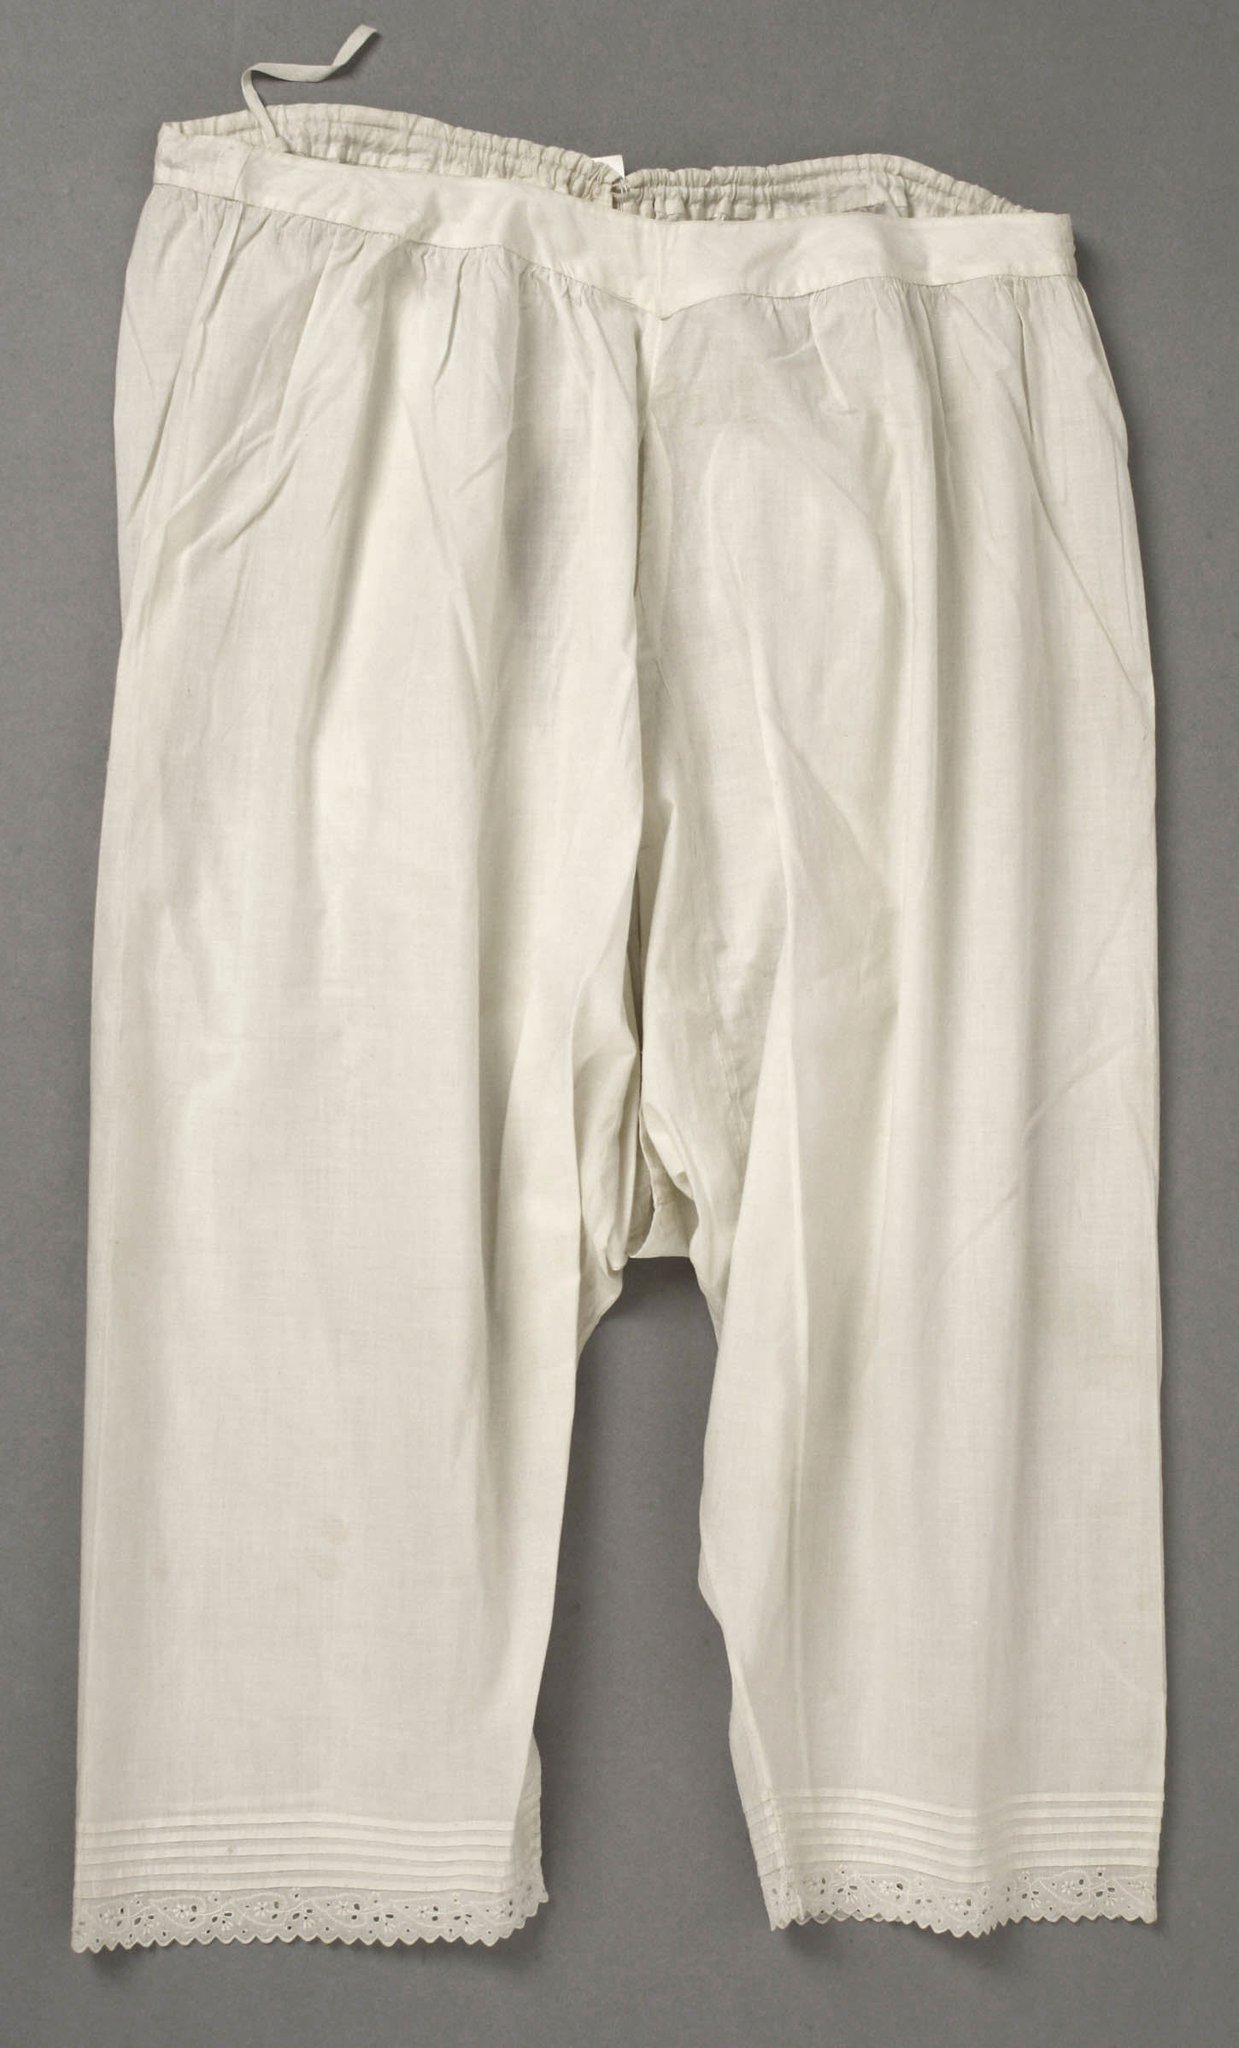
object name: drawer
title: Drawers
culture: american or european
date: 1860-1868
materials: cotton